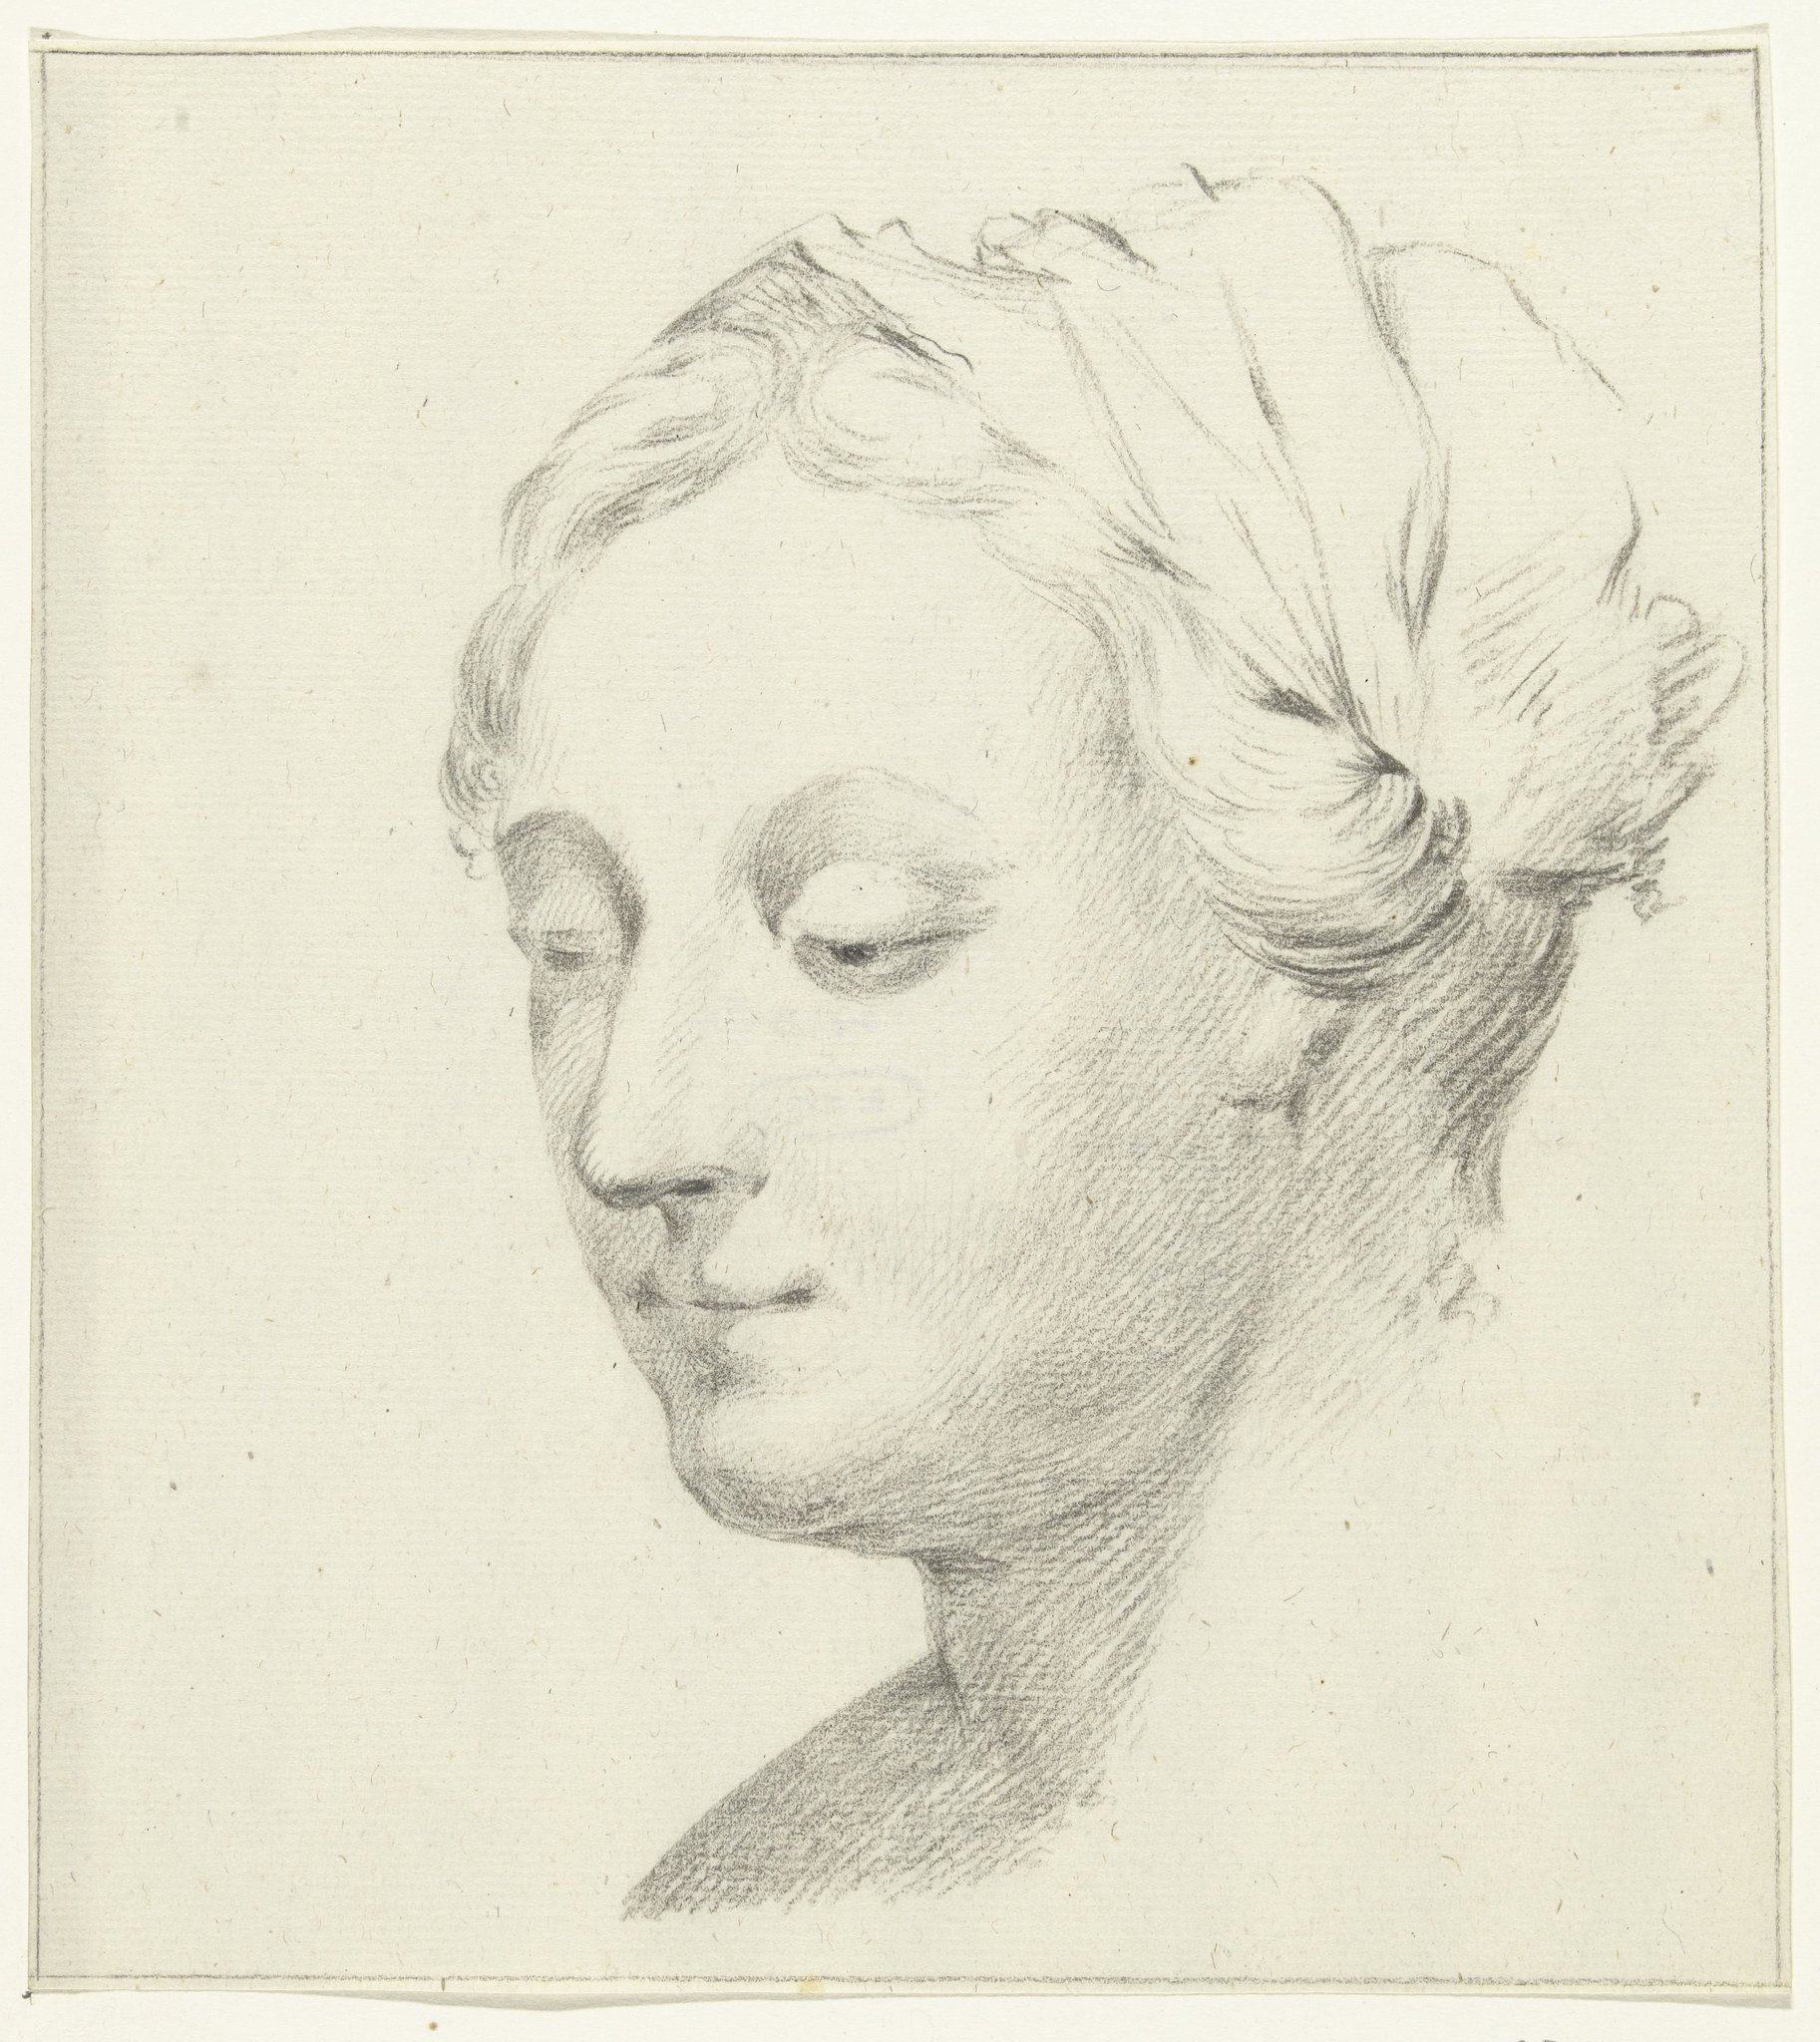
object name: drawing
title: Hoofd van een vrouw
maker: jean bernard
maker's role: draughtsman, print maker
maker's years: 1765-1833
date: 1775-1833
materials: chalk, paper, pencil